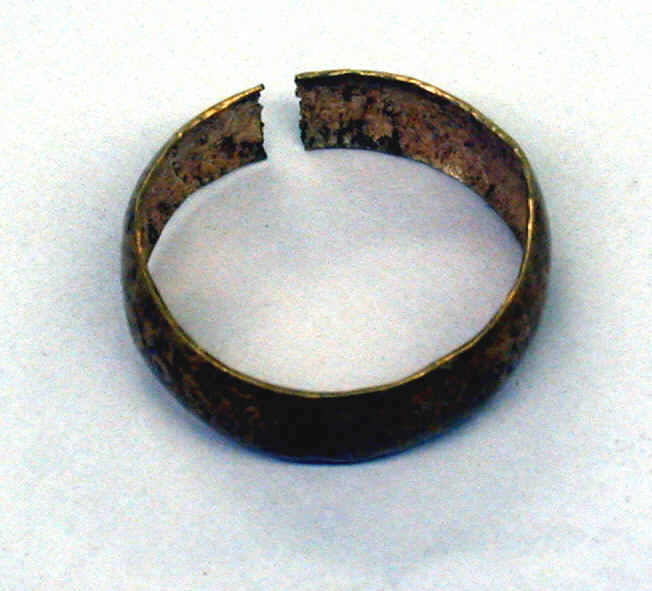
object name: ring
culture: visayes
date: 1301-1500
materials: gold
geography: philippines